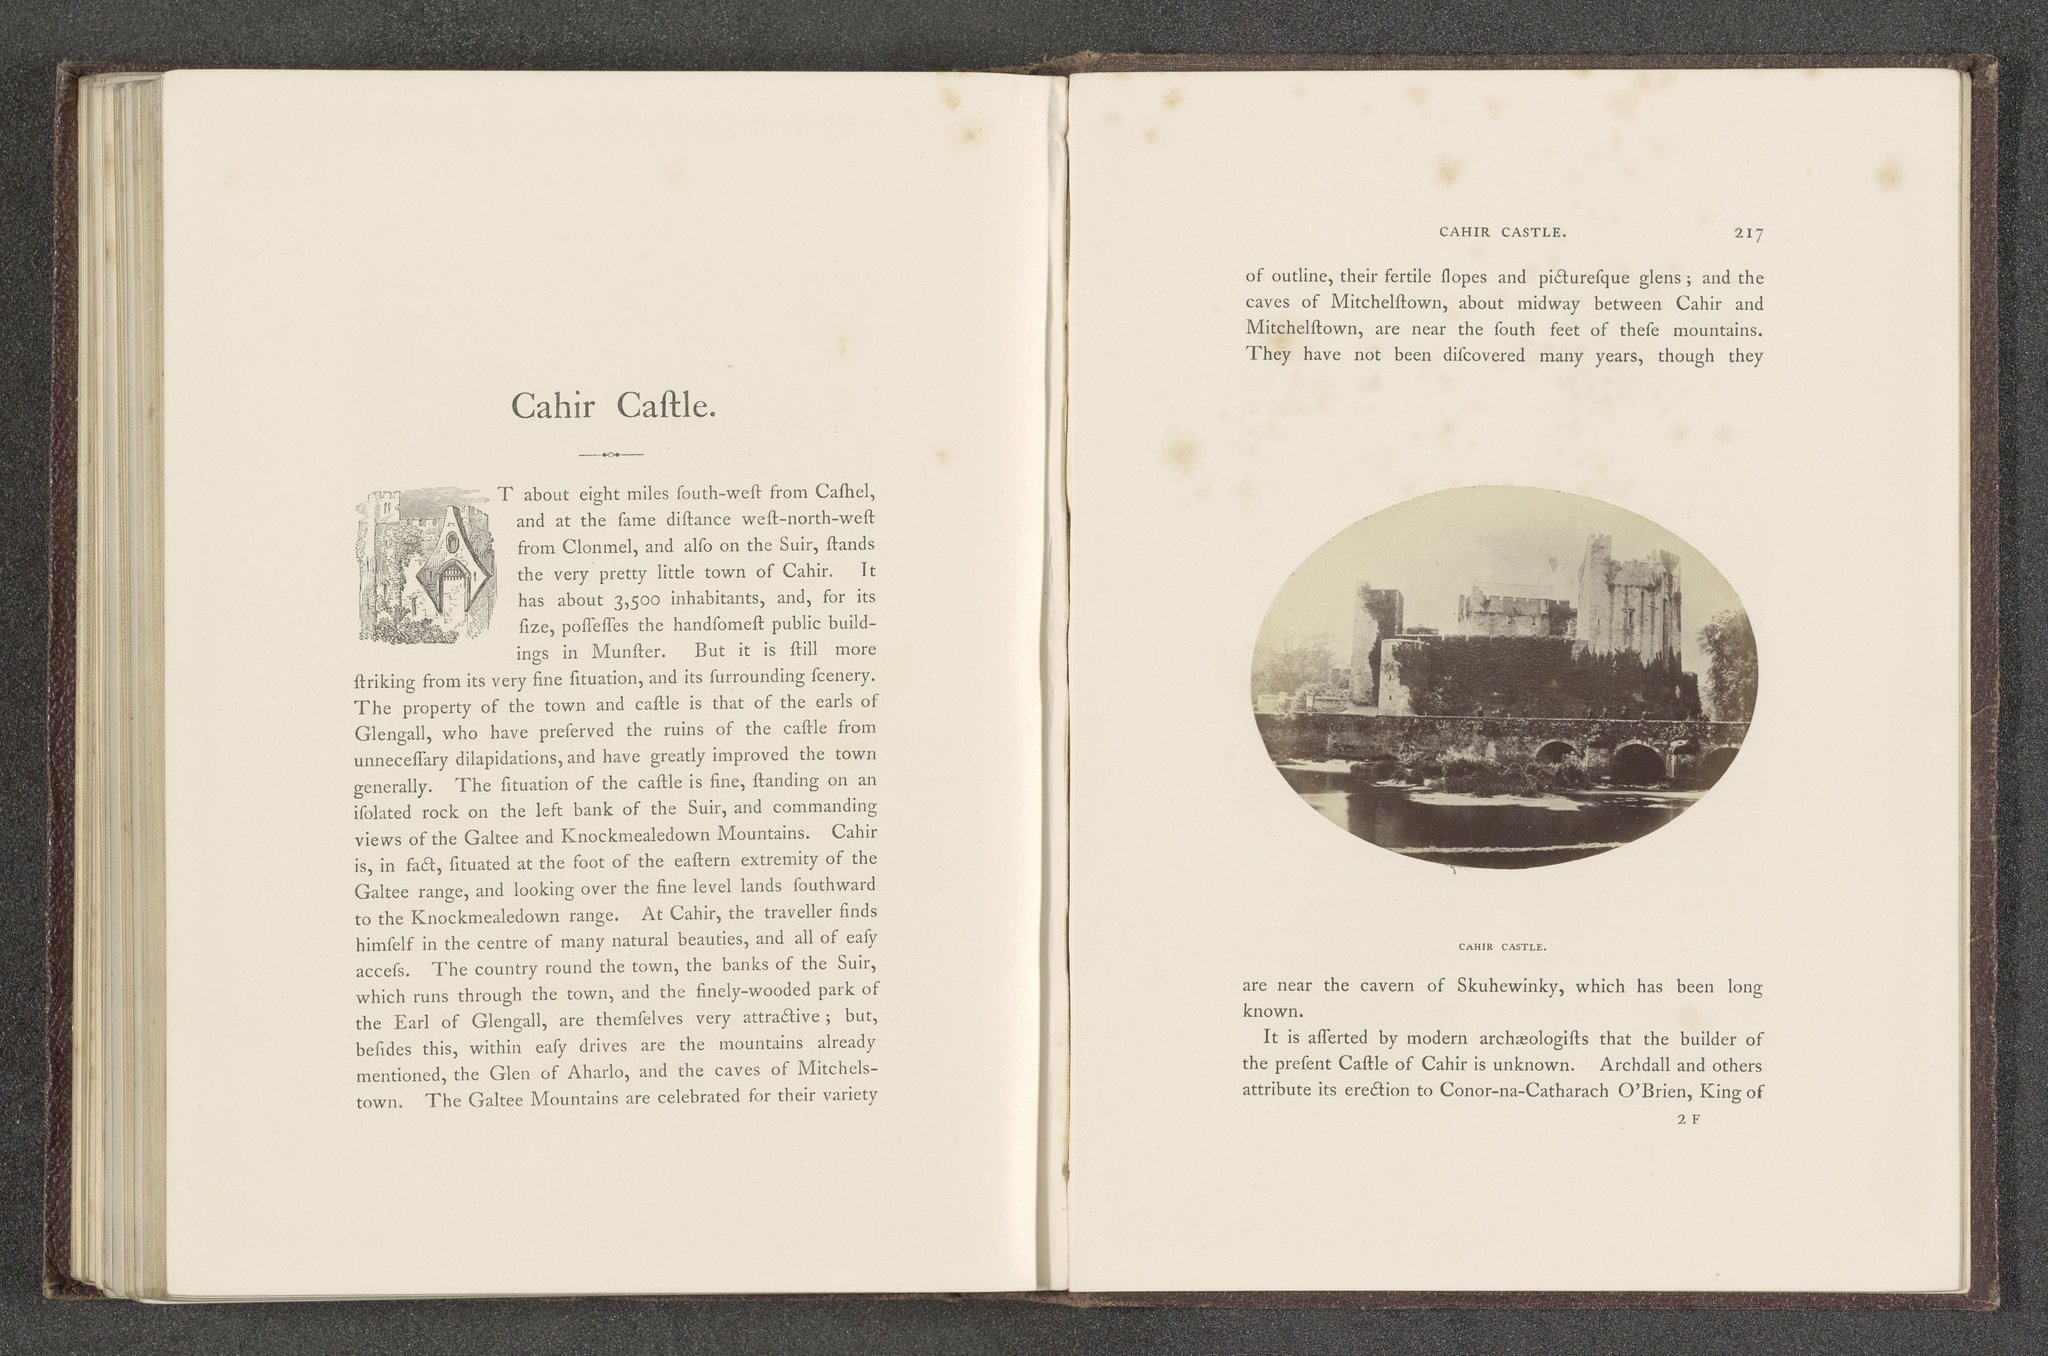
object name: page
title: Gezicht op Cahir Castle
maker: hemphill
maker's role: fotograaf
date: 1854-1864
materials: photographic support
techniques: albumen print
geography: cahir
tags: ruin of a dwelling, house, castle, etc.